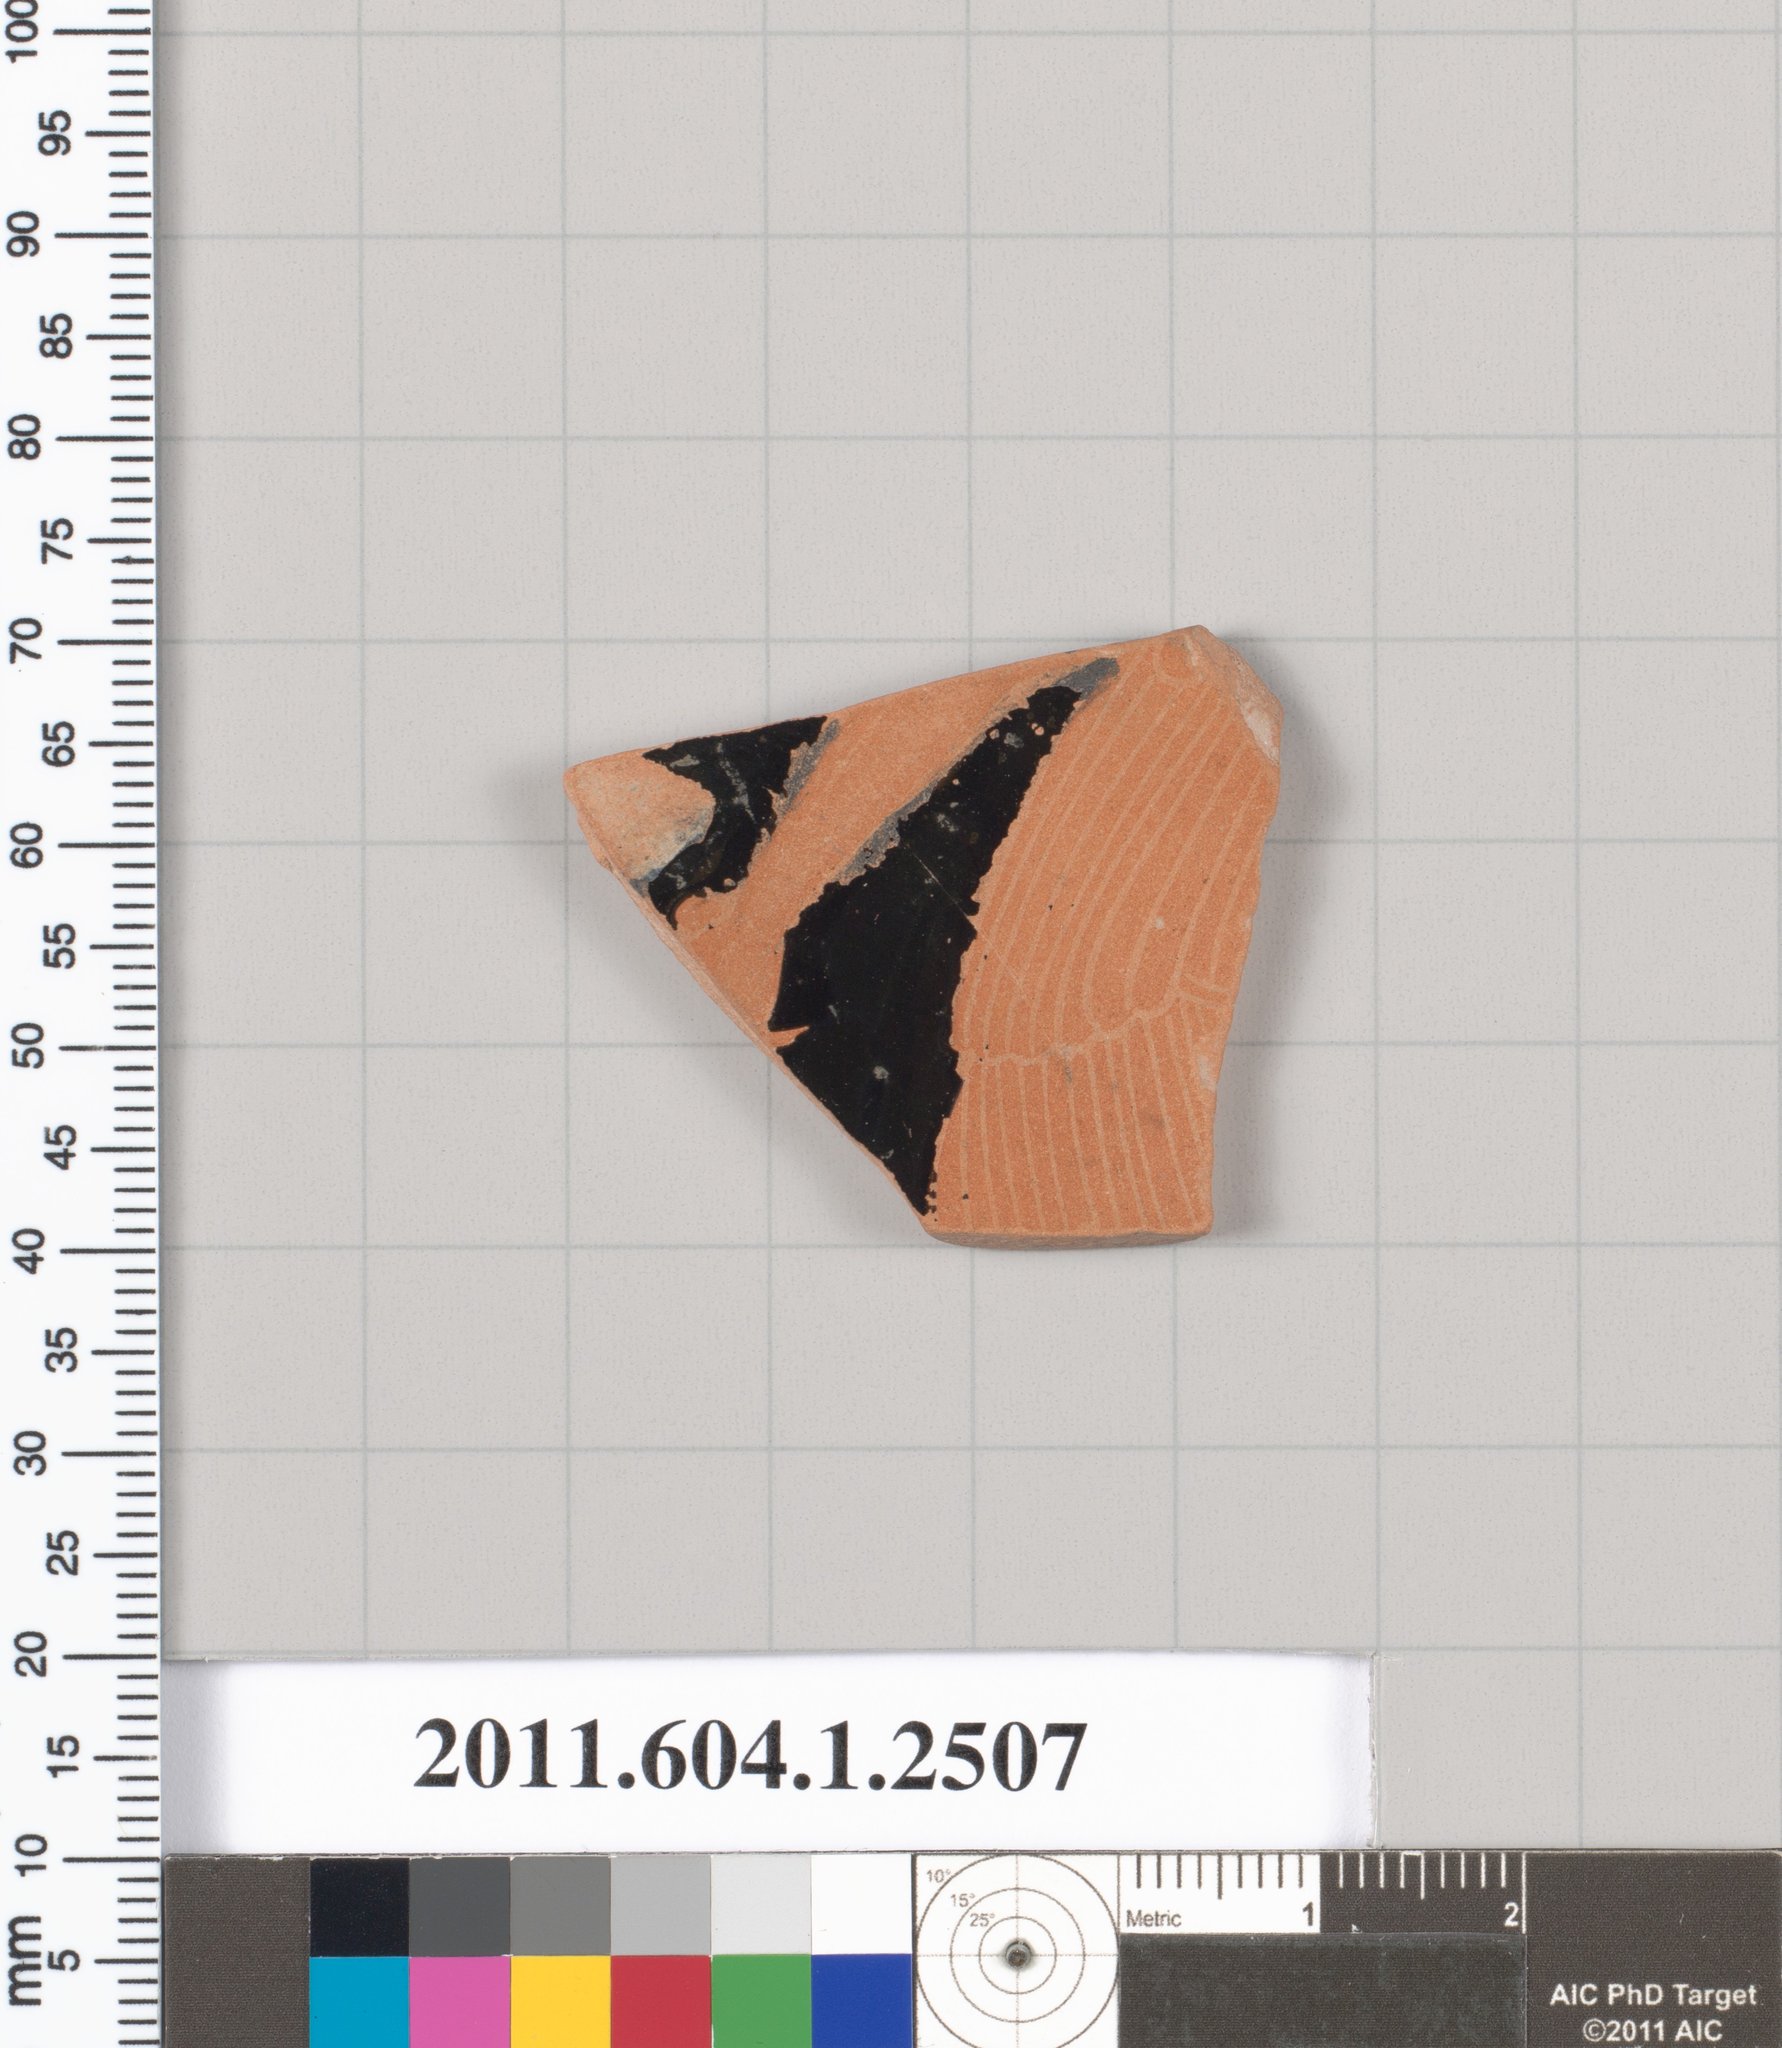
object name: kylix fragment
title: Terracotta fragment of a kylix (drinking cup)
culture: greek, attic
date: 490-480 BCE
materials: terracotta